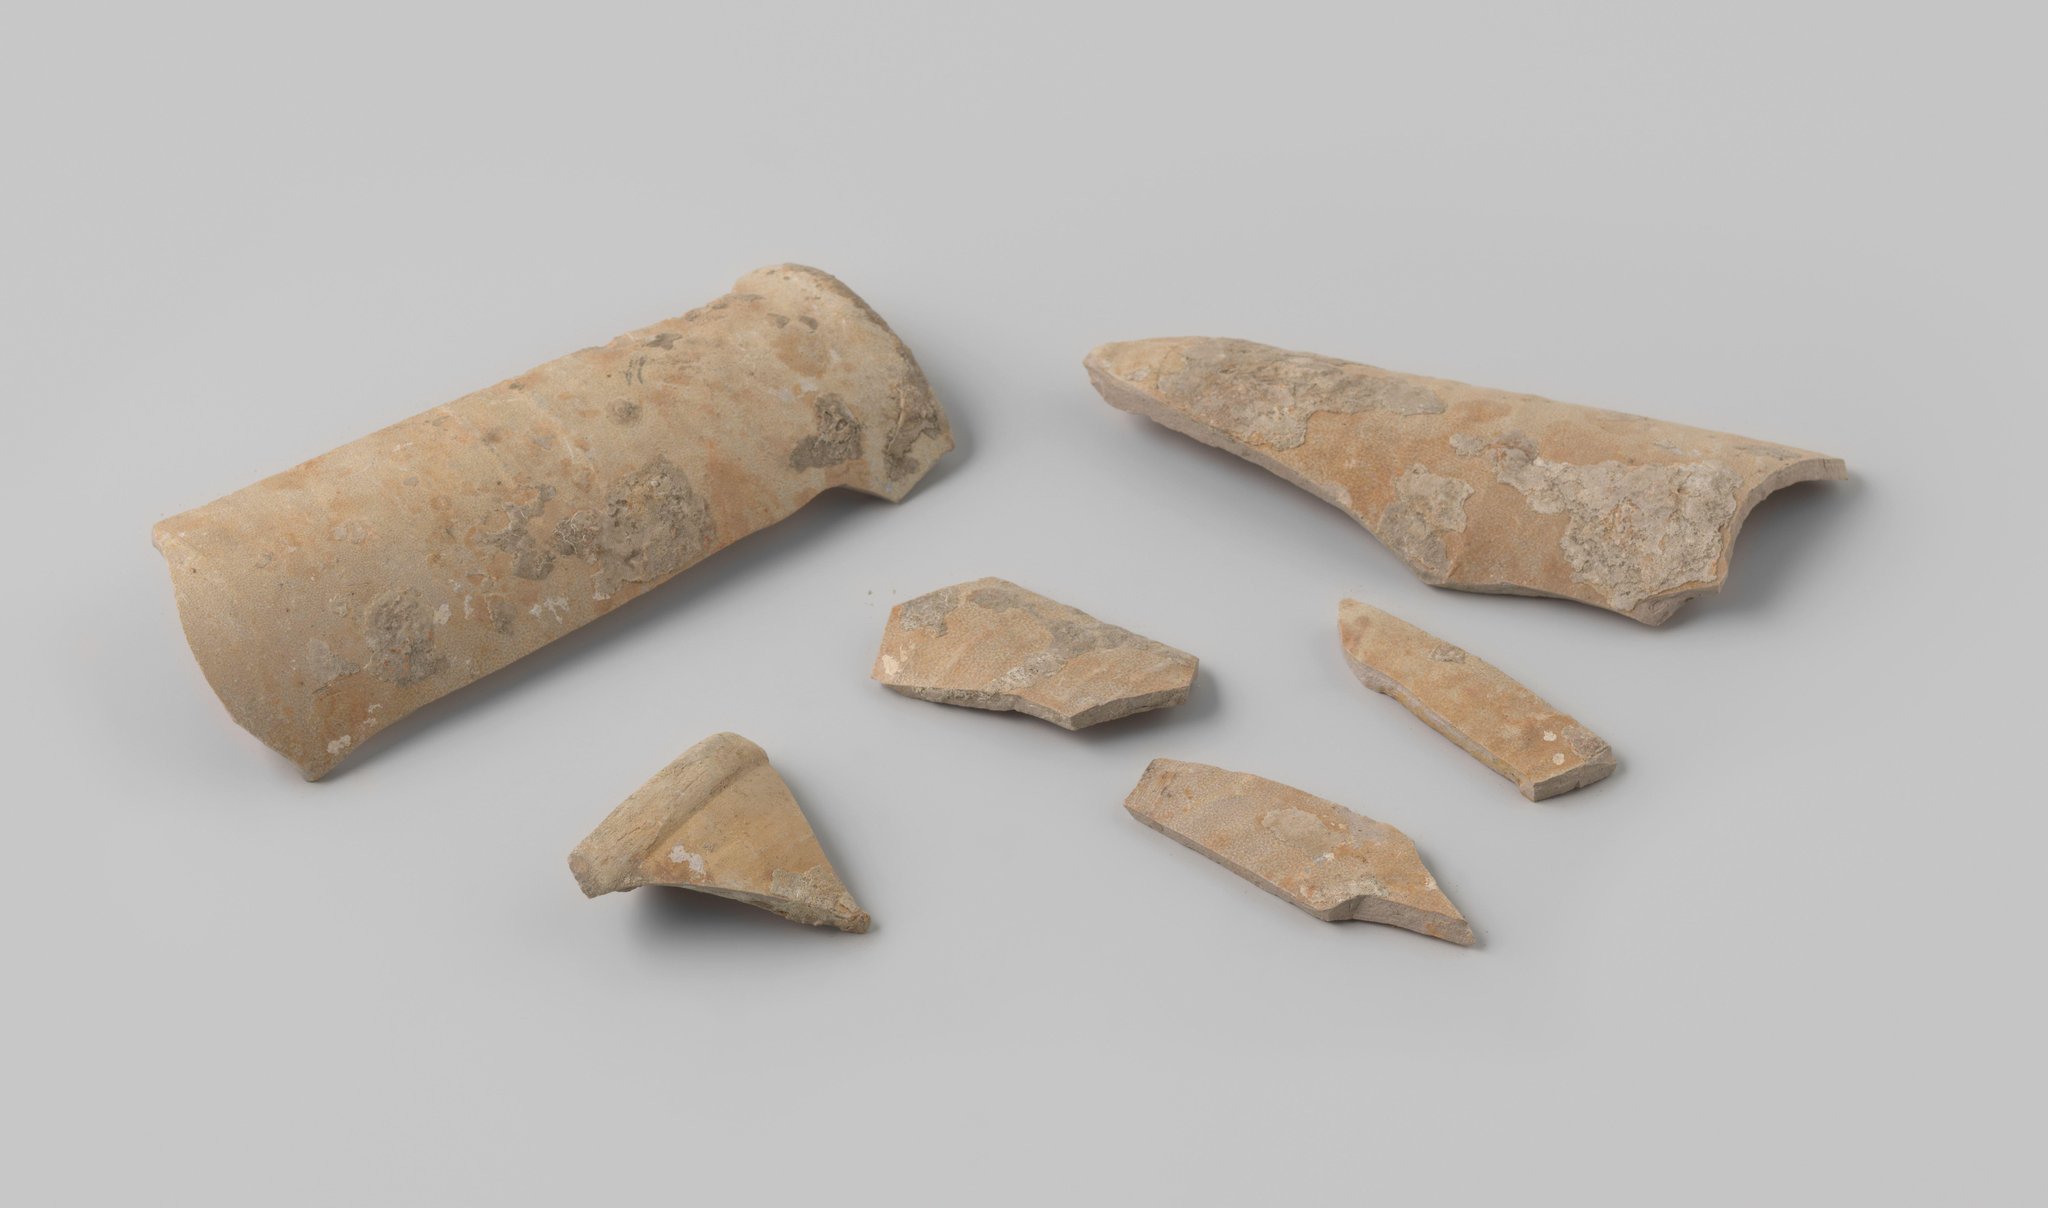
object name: sherd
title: Zak met diverse scherven steengoed uit V.O.C.-schip de 'Witte Leeuw'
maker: Anonymous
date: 1613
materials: stoneware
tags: verenigde oostindische compagnie, sint-helena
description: Zak met diverse scherven steengoed uit V.O.C.-schip de 'Witte Leeuw'.